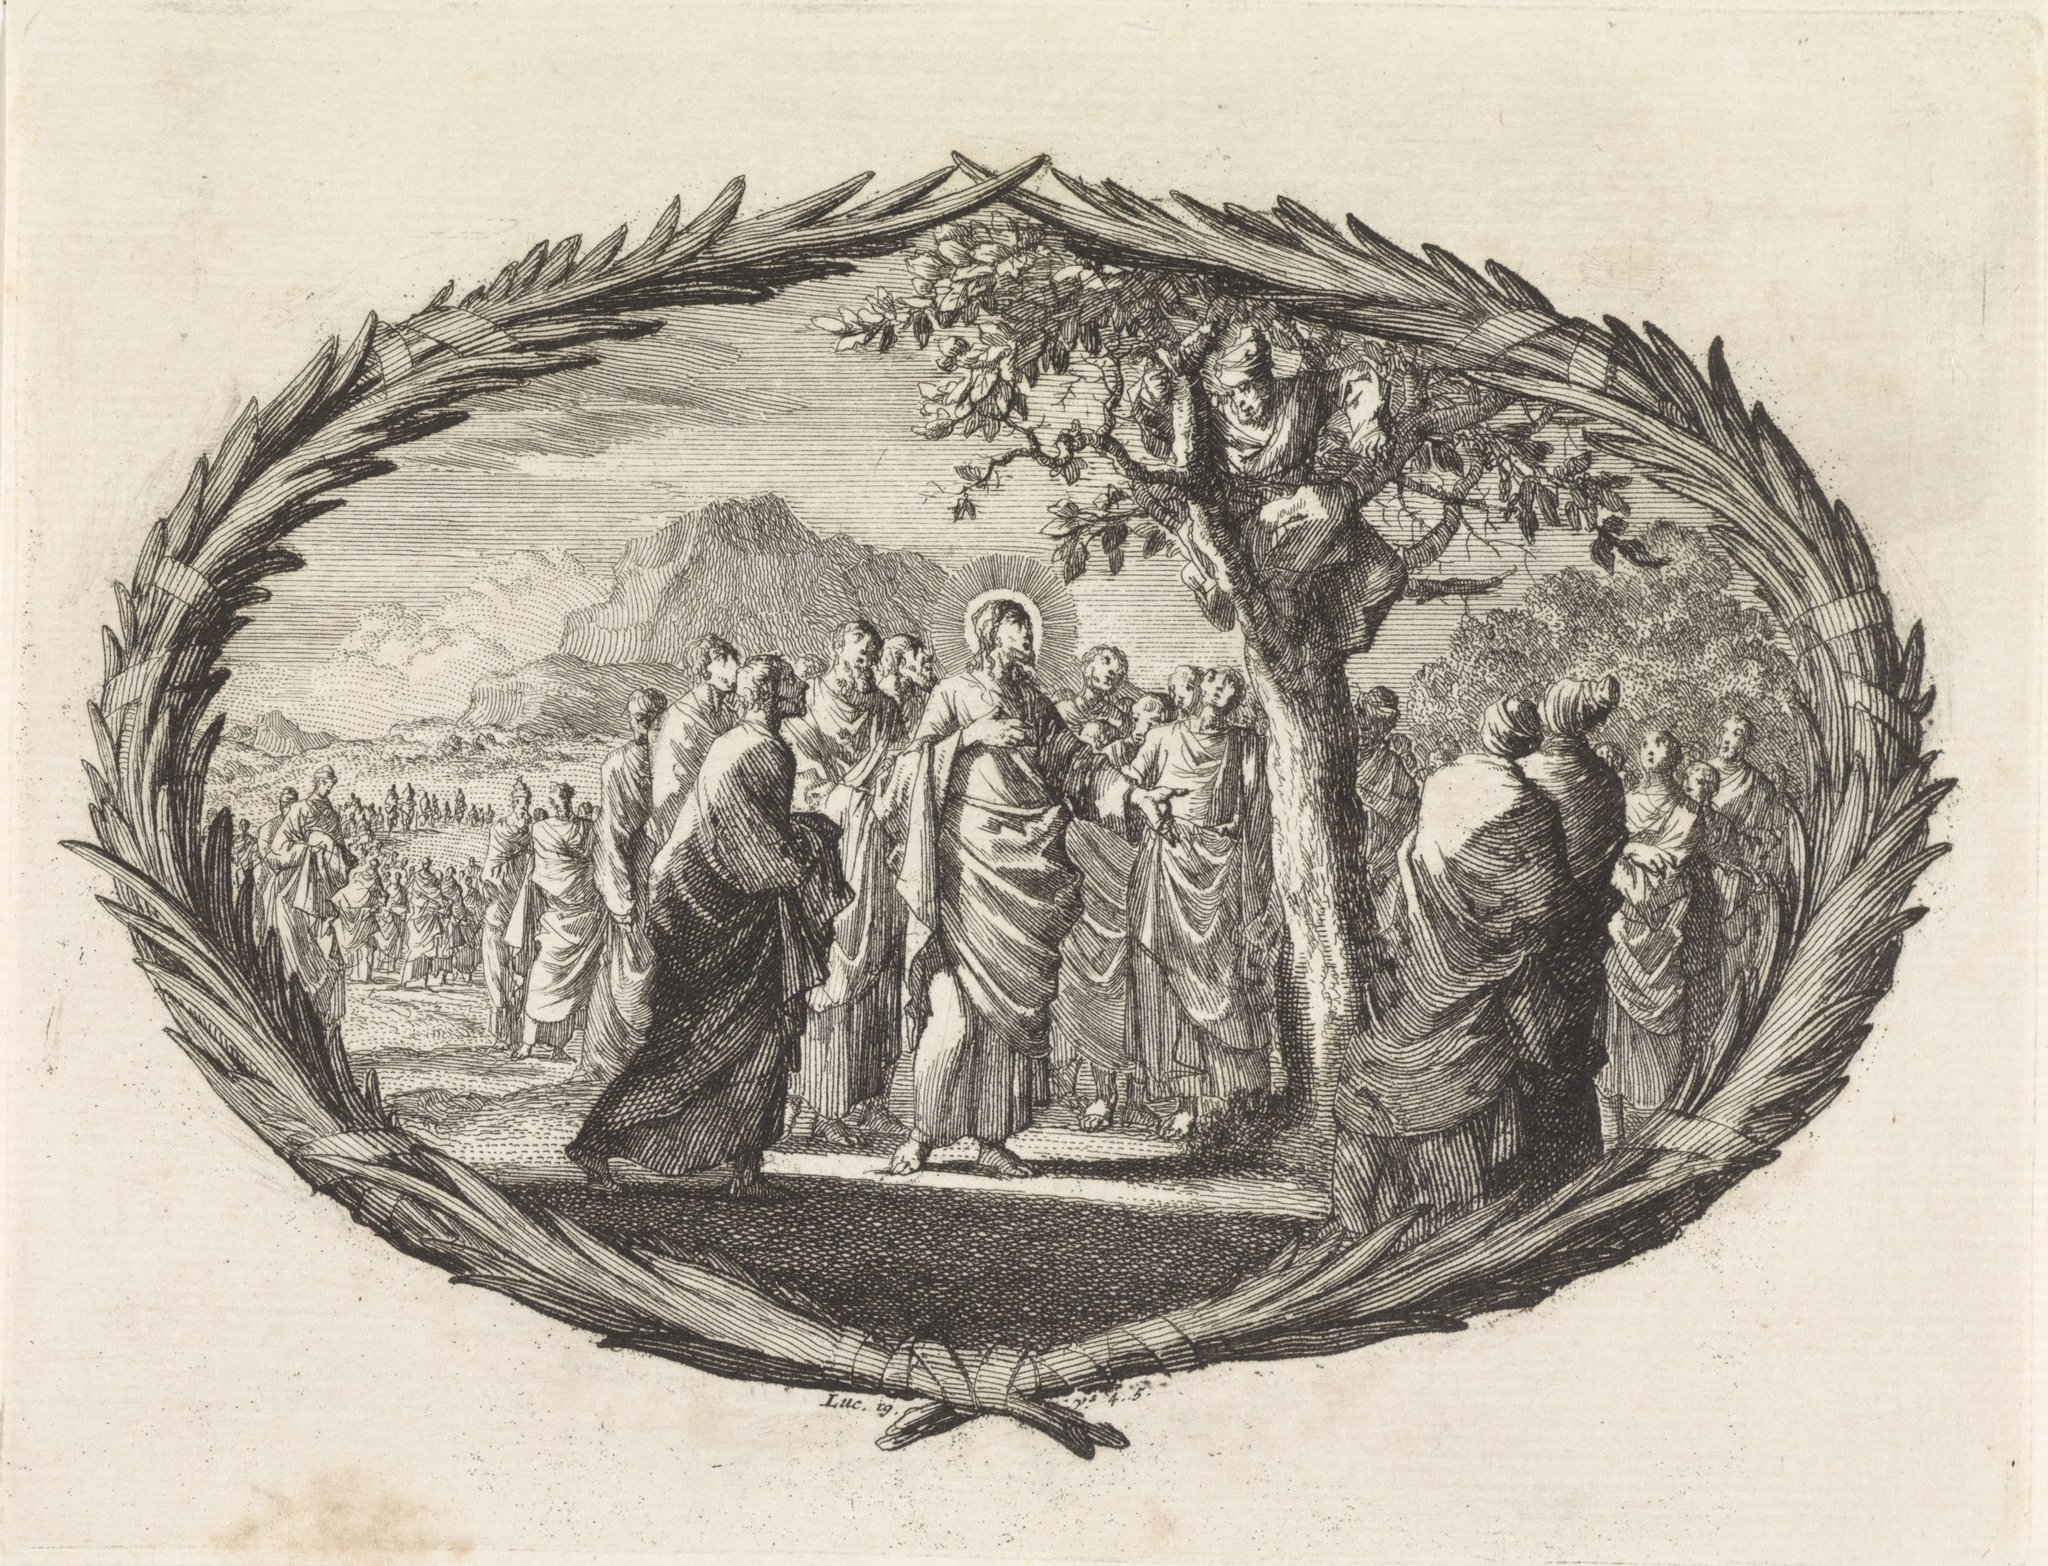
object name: print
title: Roeping van Zacheus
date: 1700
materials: paper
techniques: etching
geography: amsterdam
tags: calling of zacchaeus, who is sitting in a fig-tree (christ passing through jericho), ornament ~ cartouche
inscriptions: collector's mark: Lugt 2228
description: Een voorstelling in een cartouche van palmtakken. De tollenaar Zacheus is in een boom gekropen om Christus te zien bij zijn intocht in Jericho. Christus roept Zacheus bij zich en vergeeft hem zijn zonden. Onder de cartouche de Bijbelreferentie Luc. 19:4-5.